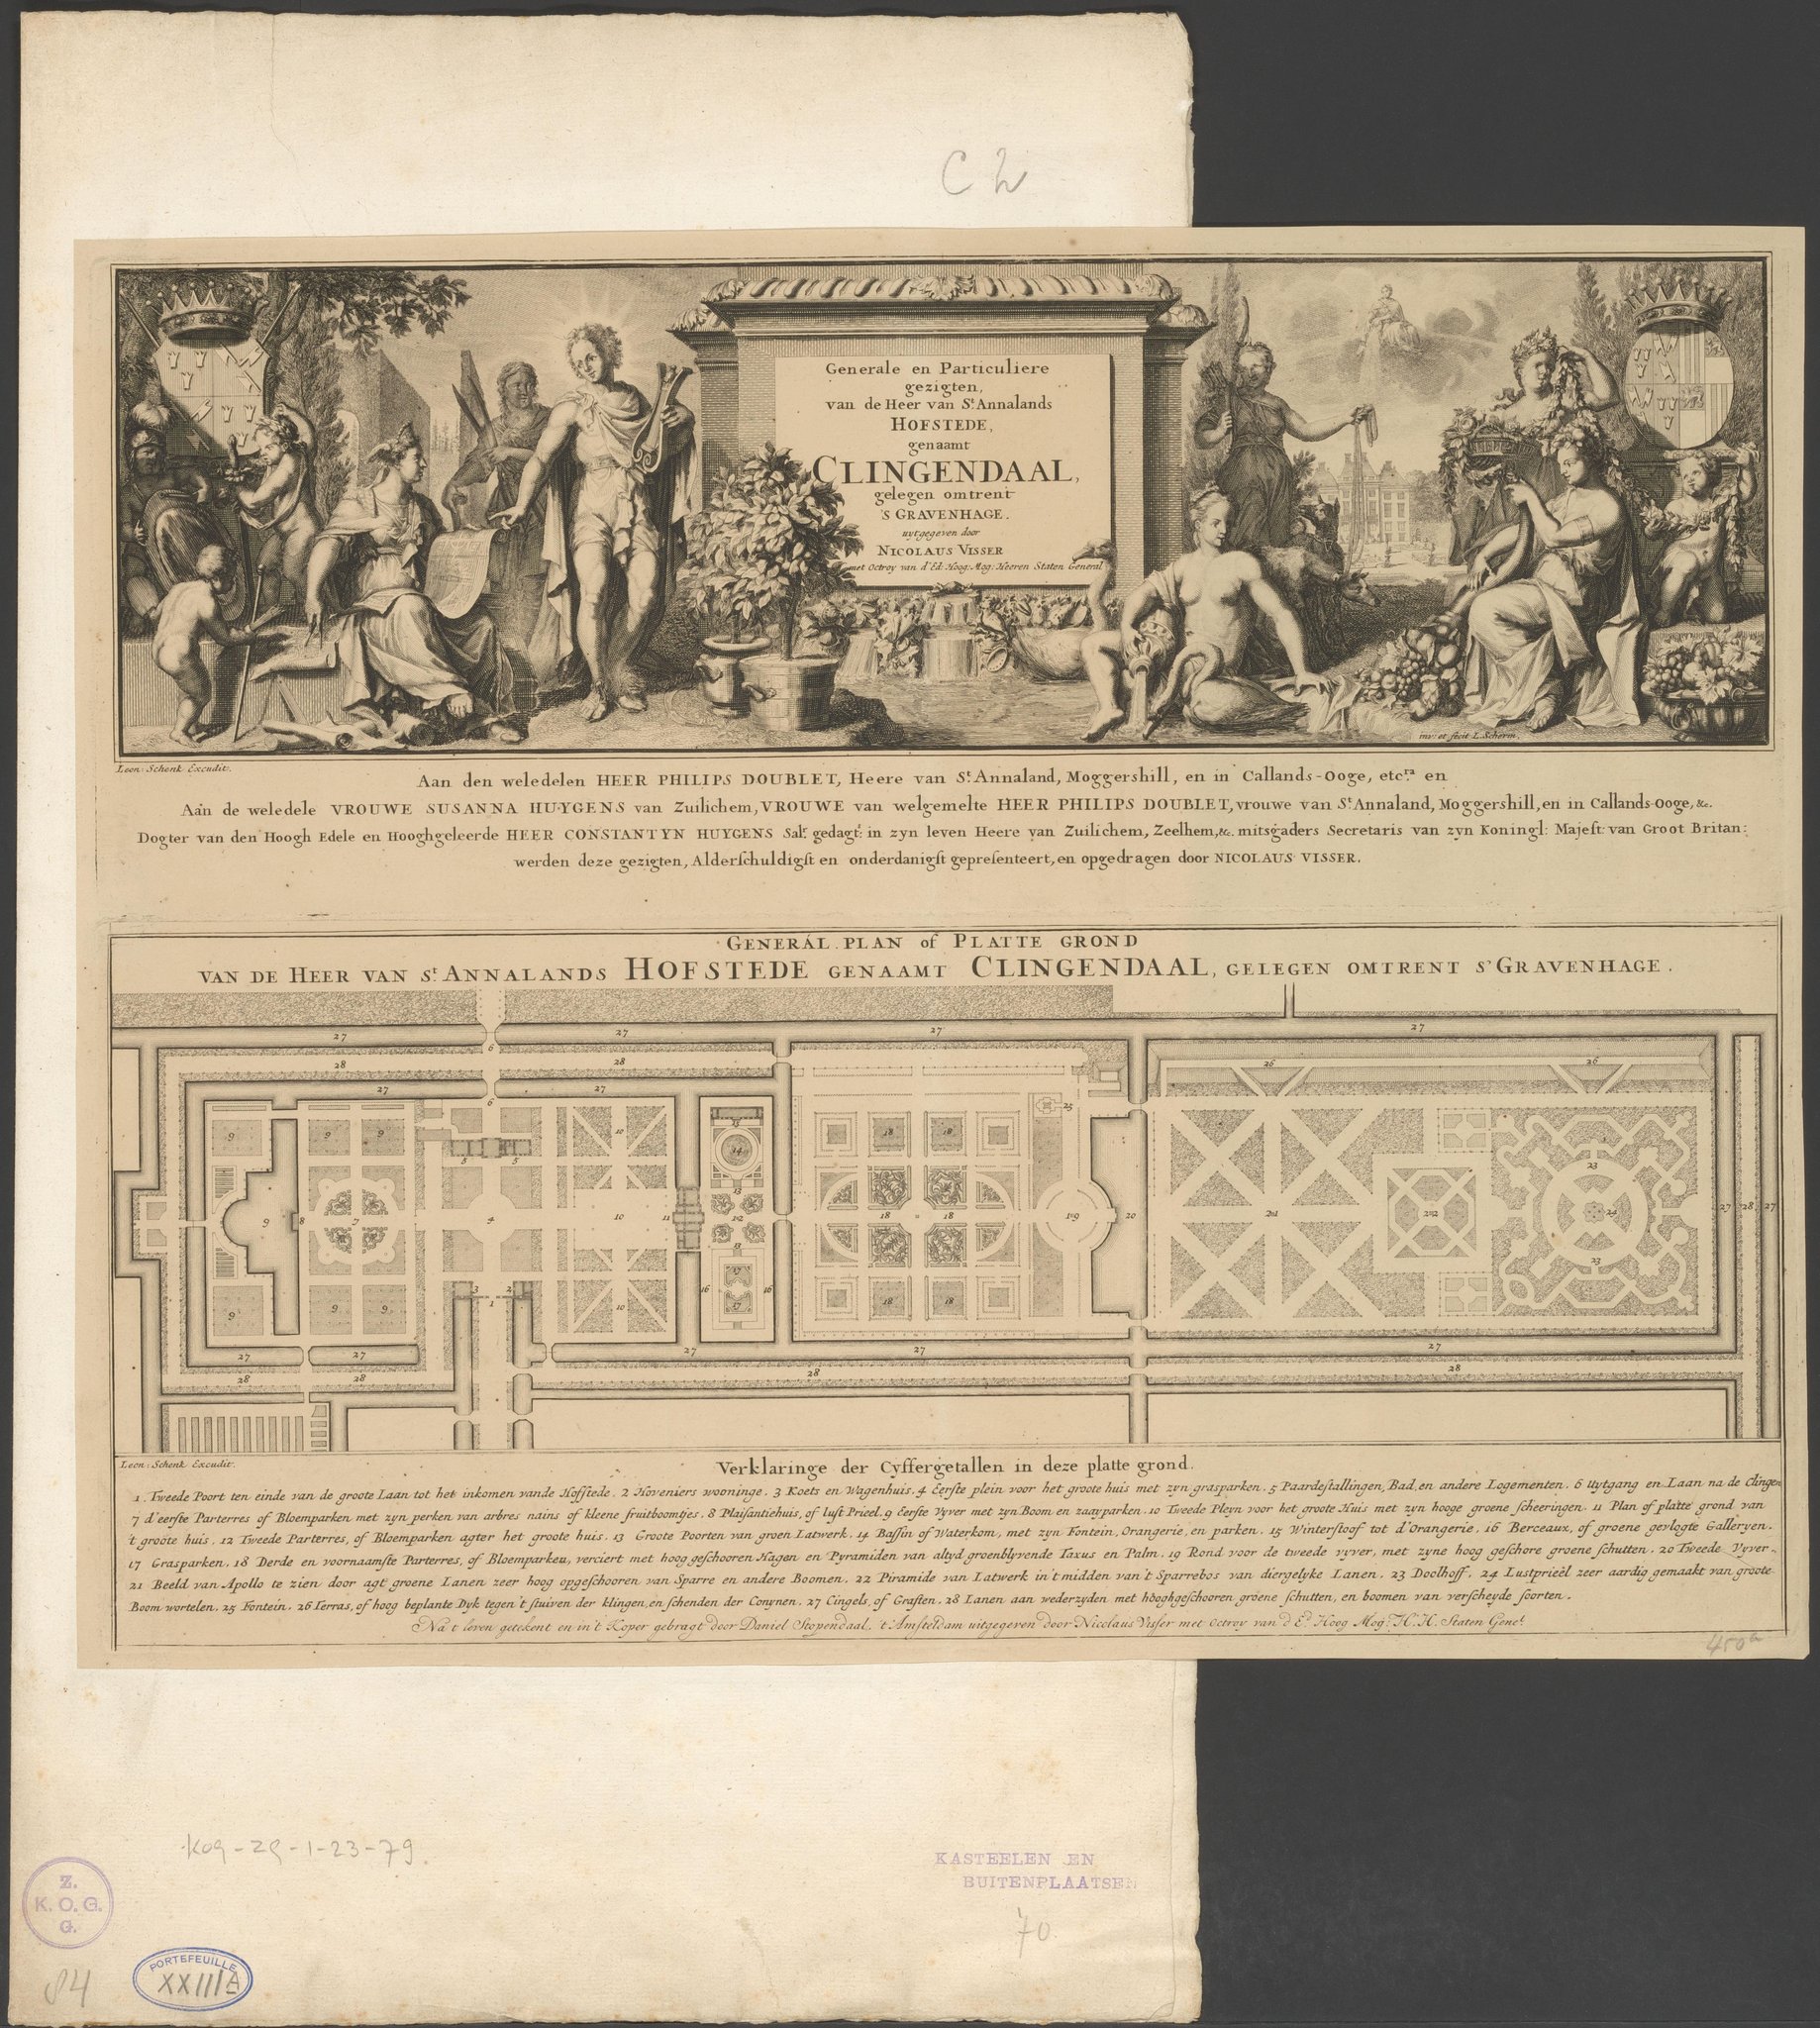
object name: print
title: General Plan of Platte Grond van de Heer van St. Annalands Hofstede genaamt Clingendaal, gelegen omtrent s' Gravenhage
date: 1706-1746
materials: paper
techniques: engraving, etching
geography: amsterdam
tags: the hague, susanna huygens, philips doublet (ii), 'cornucopia', horn of plenty, (story of) diana (artemis), (story of) apollo (phoebus), abundance; 'abondanza', 'abondanza maritima' (ripa) (+ personification), french or architectonic garden; formal garden, 'architectura', symbolic representations, allegories and emblems ~ architecture; 'architettura' (ripa), plan ~ architecture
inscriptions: stamp, collector's mark: Lugt 1641, stamp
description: Twee voorstellingen op een blad. Boven: Links van het monument met de serietitel staat Apollo als de patroon van de kunsten. Hij geeft opdracht aan Architectuur. Zij houdt plattegronden in haar hand en een passer in de andere hand. Geheel links spelen putti onder het wapenschild van de eigenaar van het landgoed: Philips Doublet (II). Rechts staat Diana als patrones van de jacht met haar boog en jachthonden. Geheel rechts Flora, met een bloemenmand, en Overvloed met een hoorn des overvloeds. Zij staan bij het wapenschild van Susanna Huygens, de vrouw van Philips Doublet. Onder: Plattegrond van landgoed Clingendael bij Den Haag. Onderaan een legenda 1-28 in het Nederlands. Onderwerpsrubrieken binnen de Atlas Zeden en Gewoonten: Zeden en Gewoonten in Engeren Zin, De Woning. Kastelen en buitenplaatsen. Holland.